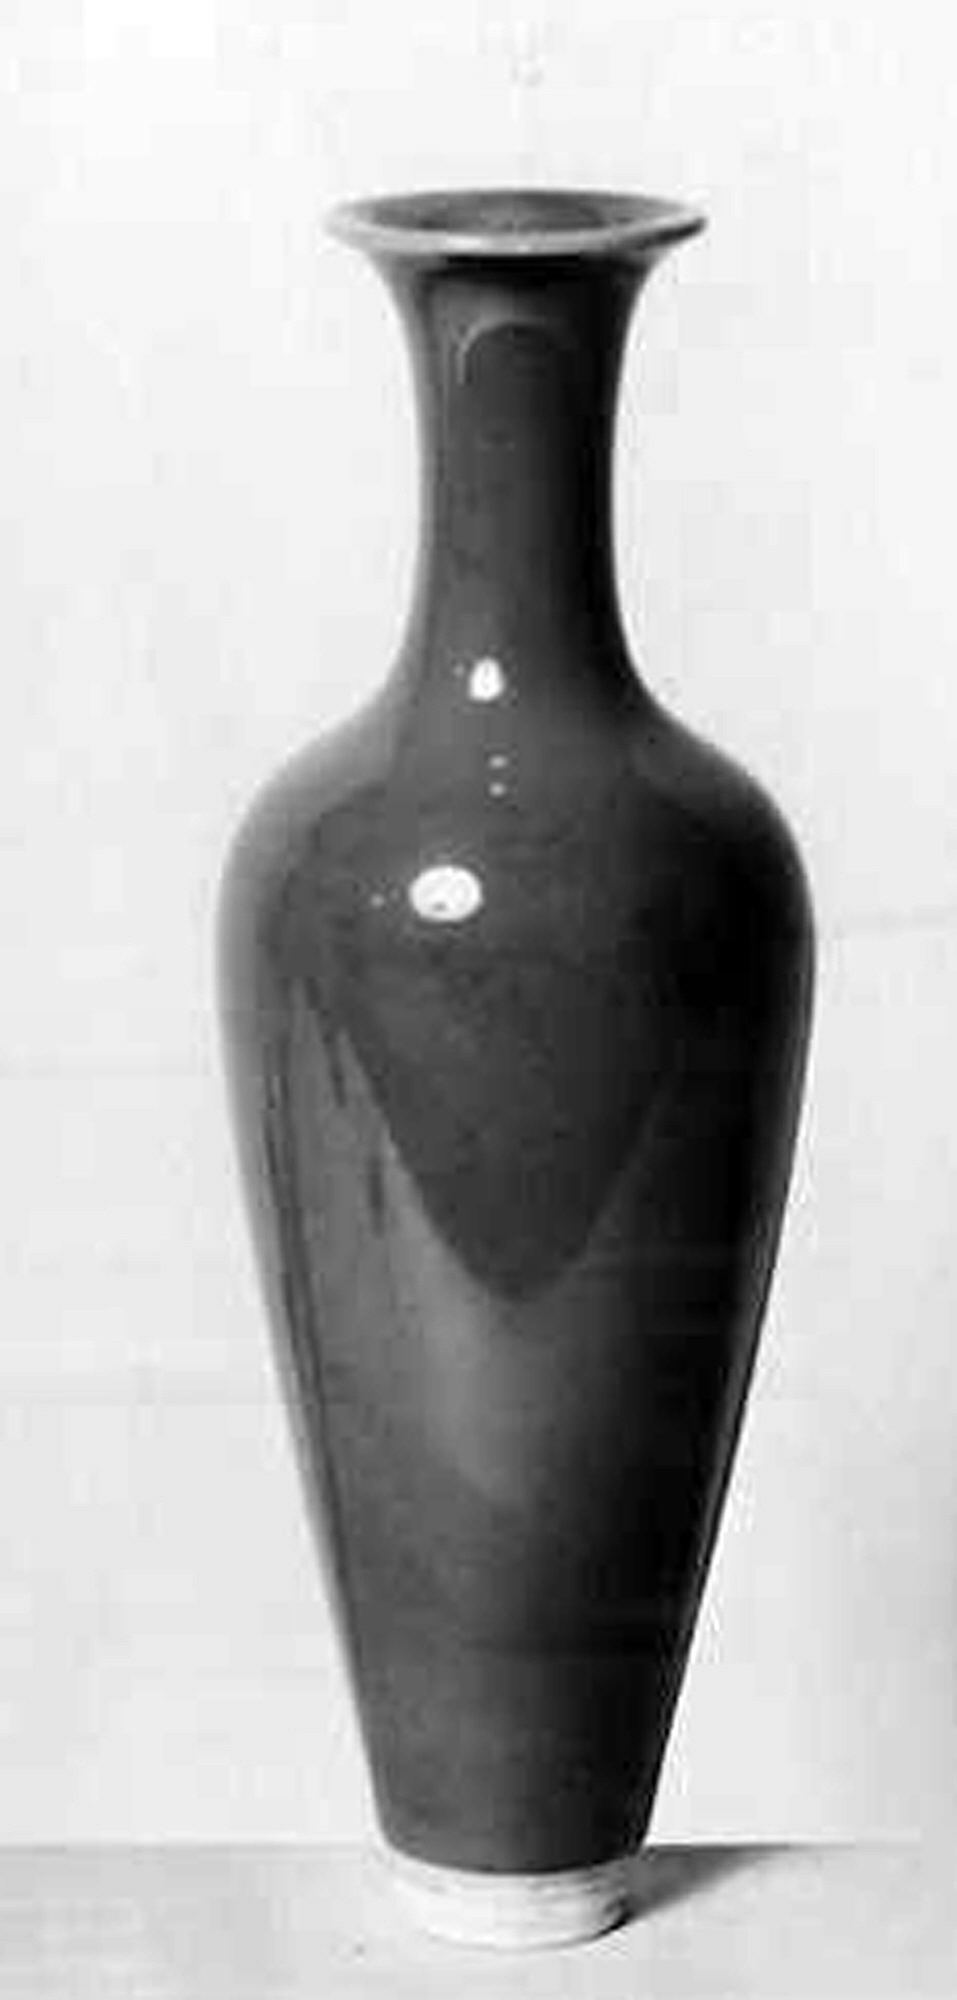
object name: amphora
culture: chinese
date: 1662-1722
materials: porcelain